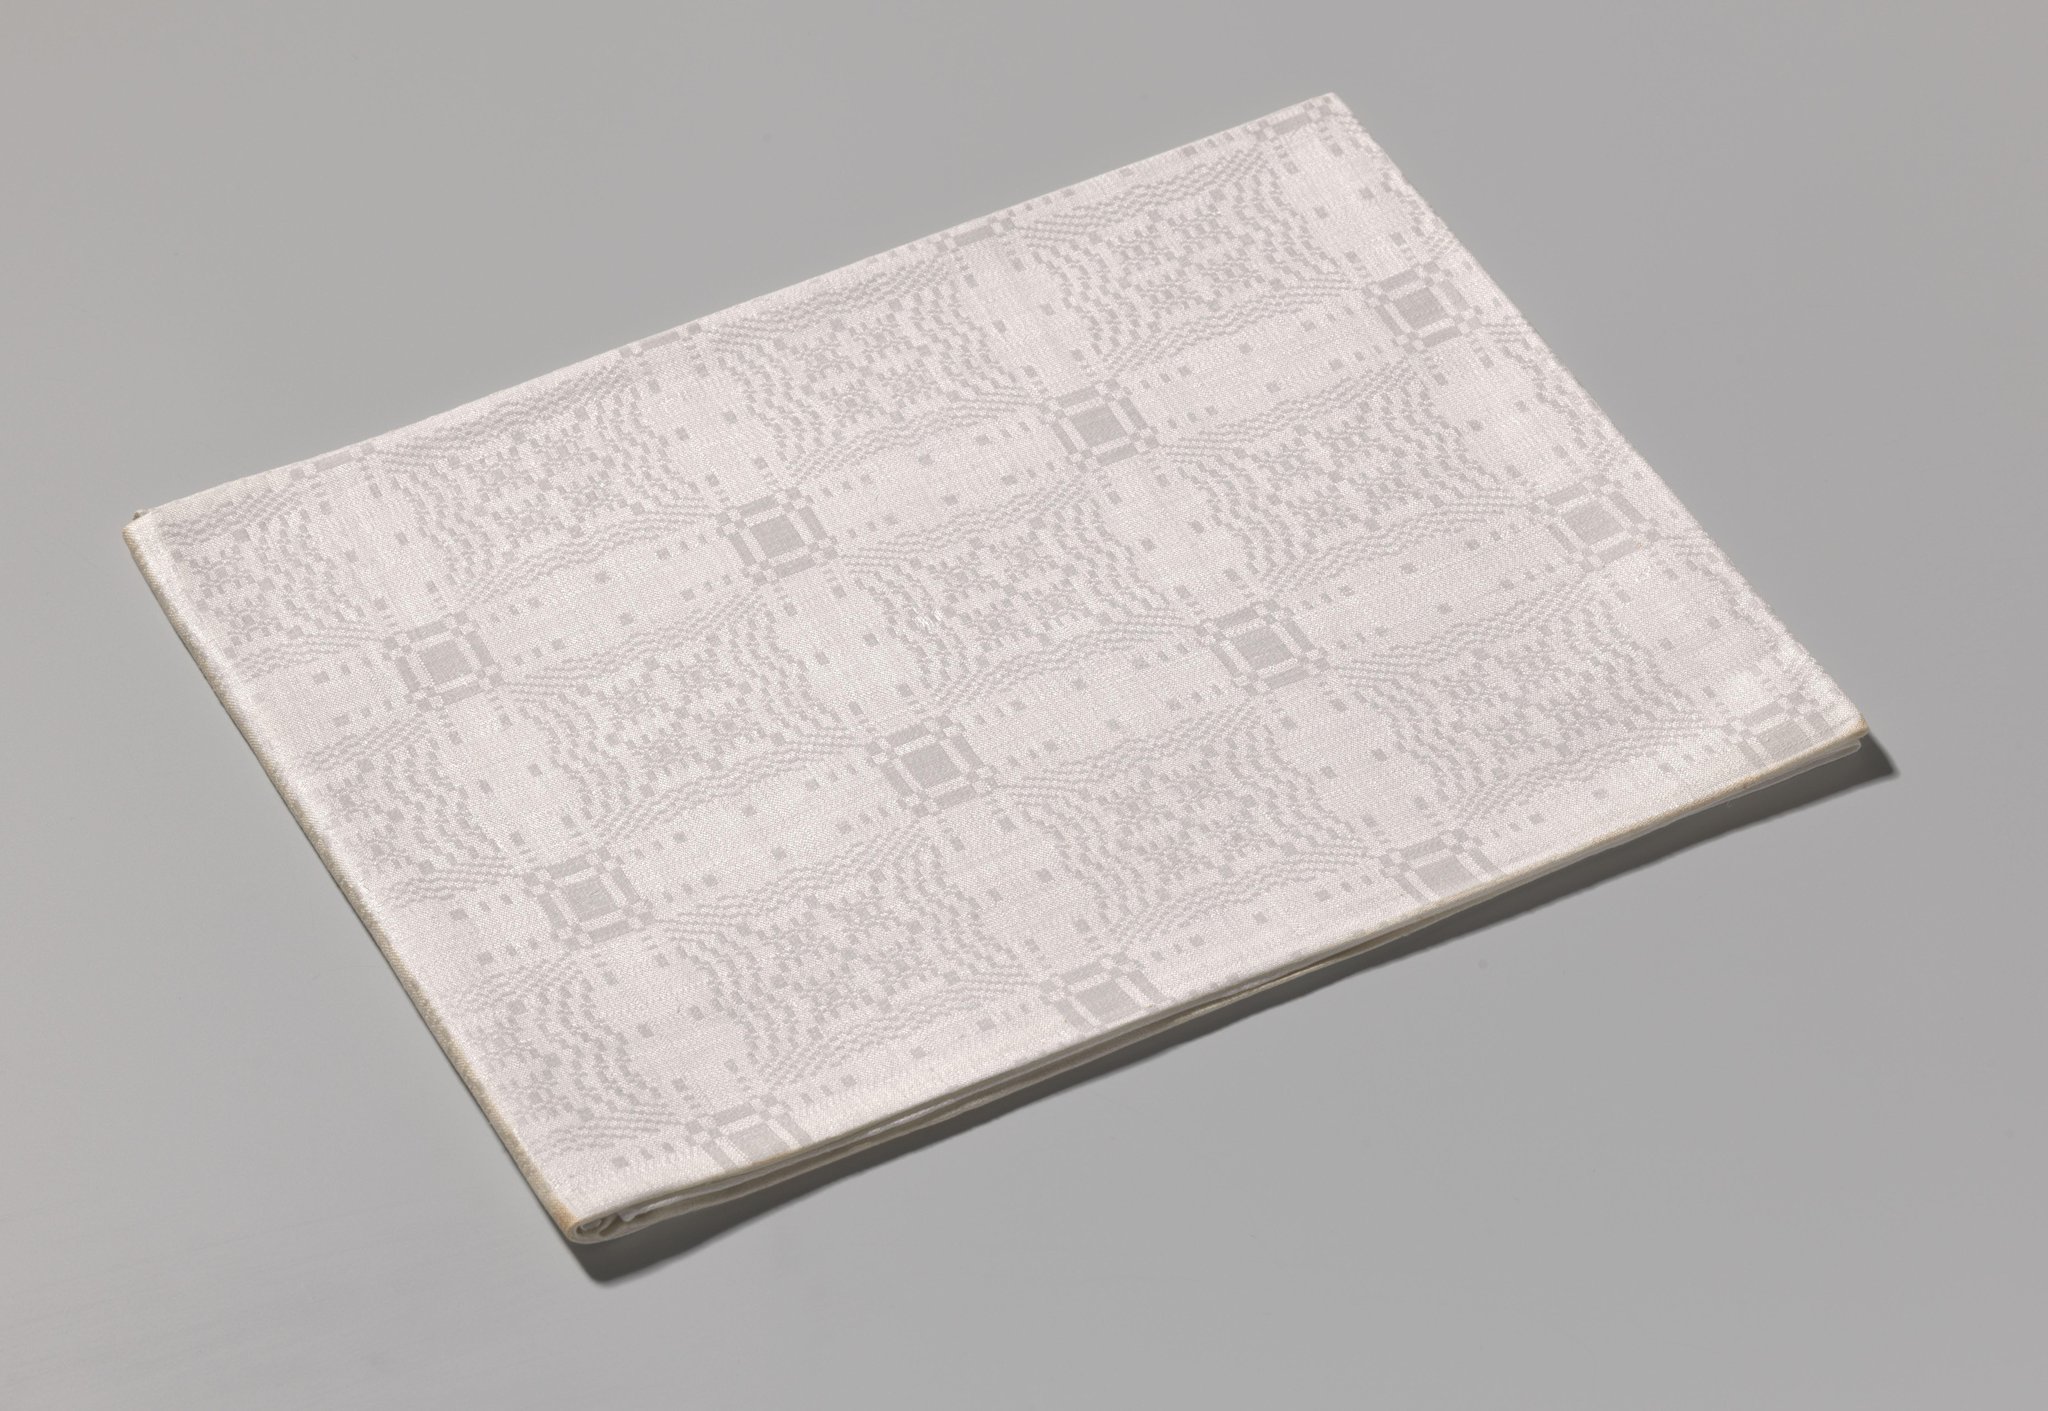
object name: napkin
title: Servet van linnen met pellenpatroon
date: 1400-1950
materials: linen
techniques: peeled fabric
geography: northern netherlands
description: Wit linnendamasten servet met pellenpatroon, merk kroon IS en 96.